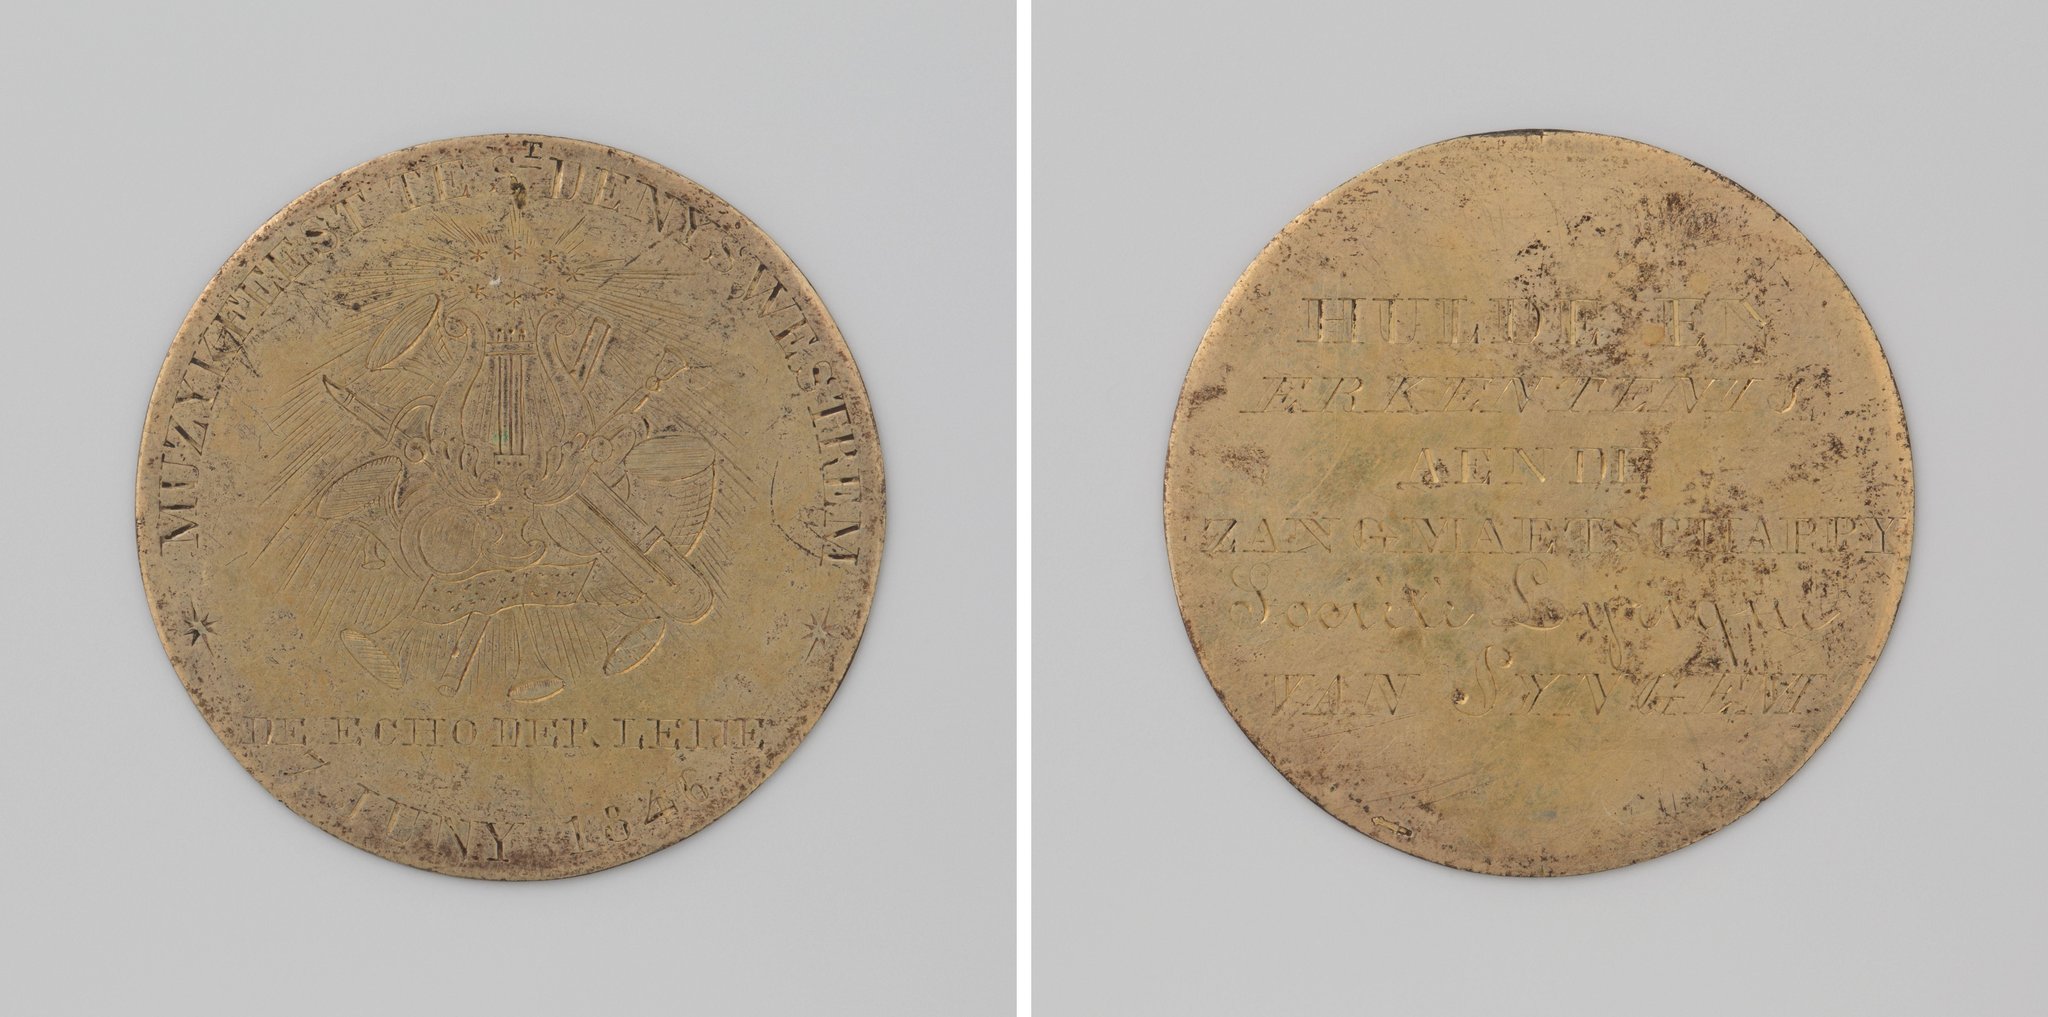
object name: medal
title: Muziekfestival van de vereniging Echo der Leie te Sint Denijs-Westrem, penning uitgereikt aan de Zangmaatschappij Societe Lyrique uit Syngem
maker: Anonymous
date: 1846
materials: metal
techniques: engraving, gilding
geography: belgium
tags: société lyrique, zangmaatschappij, echo der leie, sint-denijs-westrem, syngem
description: Vergulden penning. Voorzijde: muziekinstrumenten boven opschrift binnen omschrift. Keerzijde: opschrift.